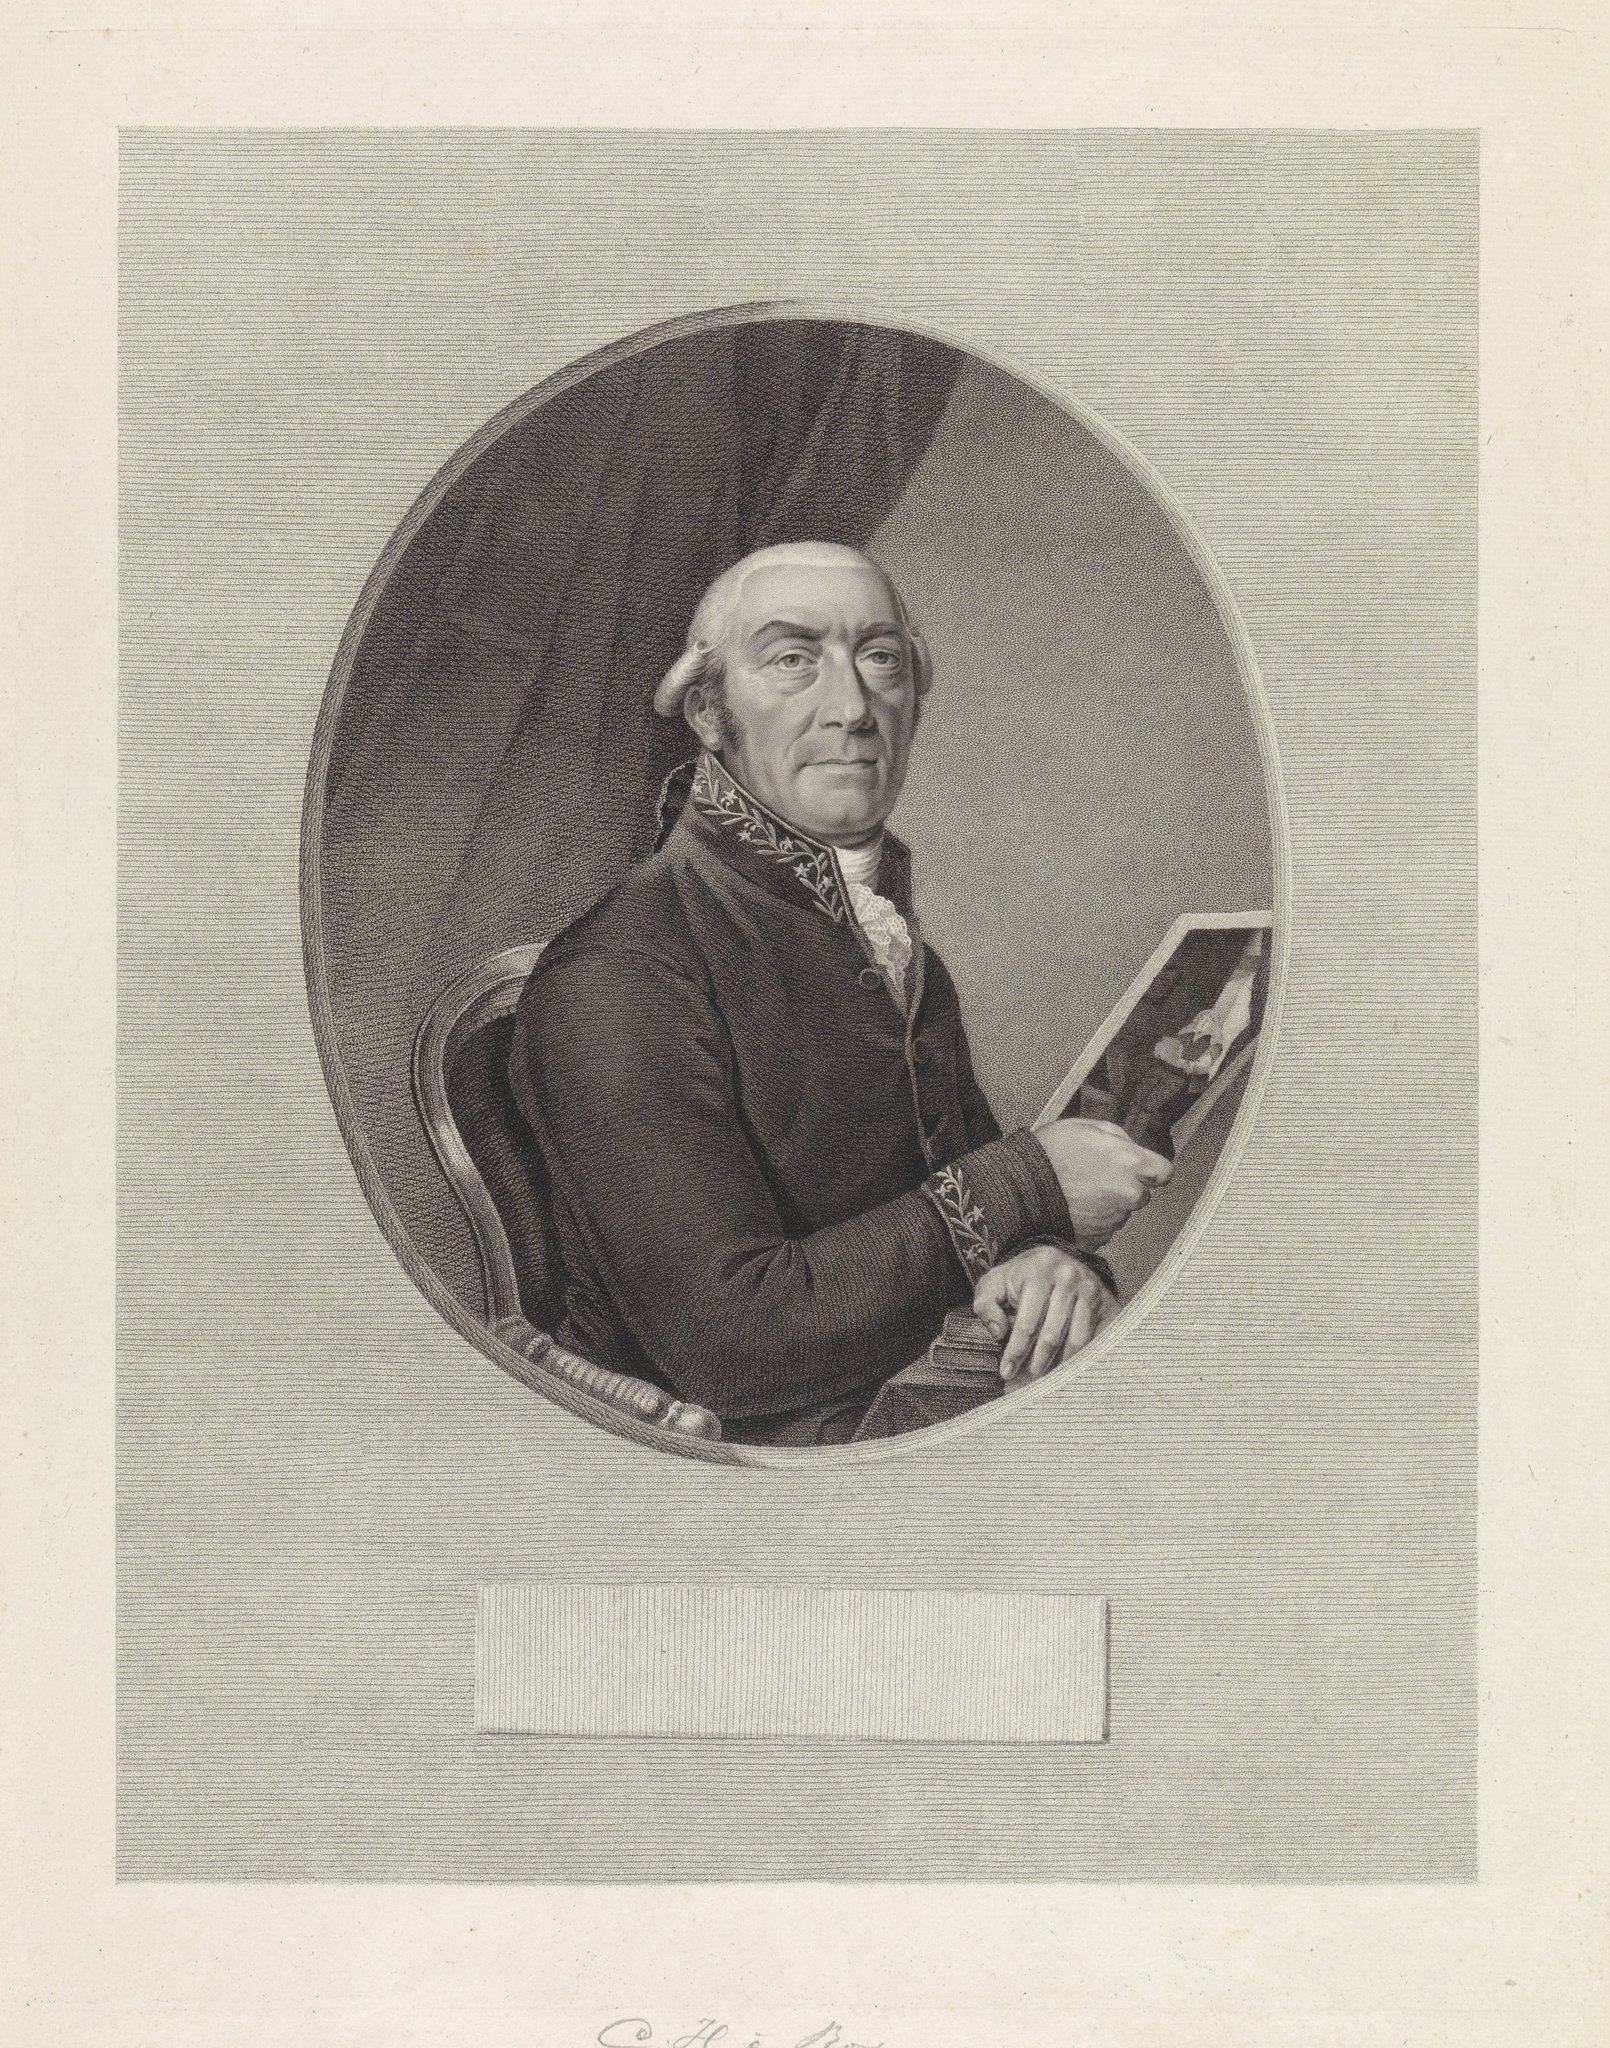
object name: print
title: Portret van Cornelius Henricus à Roy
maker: ludwig gottlieb portman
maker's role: print maker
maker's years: 1772-1828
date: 1794-1828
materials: paper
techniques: etching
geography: amsterdam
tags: print, e.g.: engraving, etching, lithograph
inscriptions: collector's mark: Lugt 2228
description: Portret van Cornelius Henricus à Roy, lijfarts van Lodewijk Napoleon. In zijn rechterhand houdt hij een afdruk van de ets met het portret van Jan Six door Rembrandt.